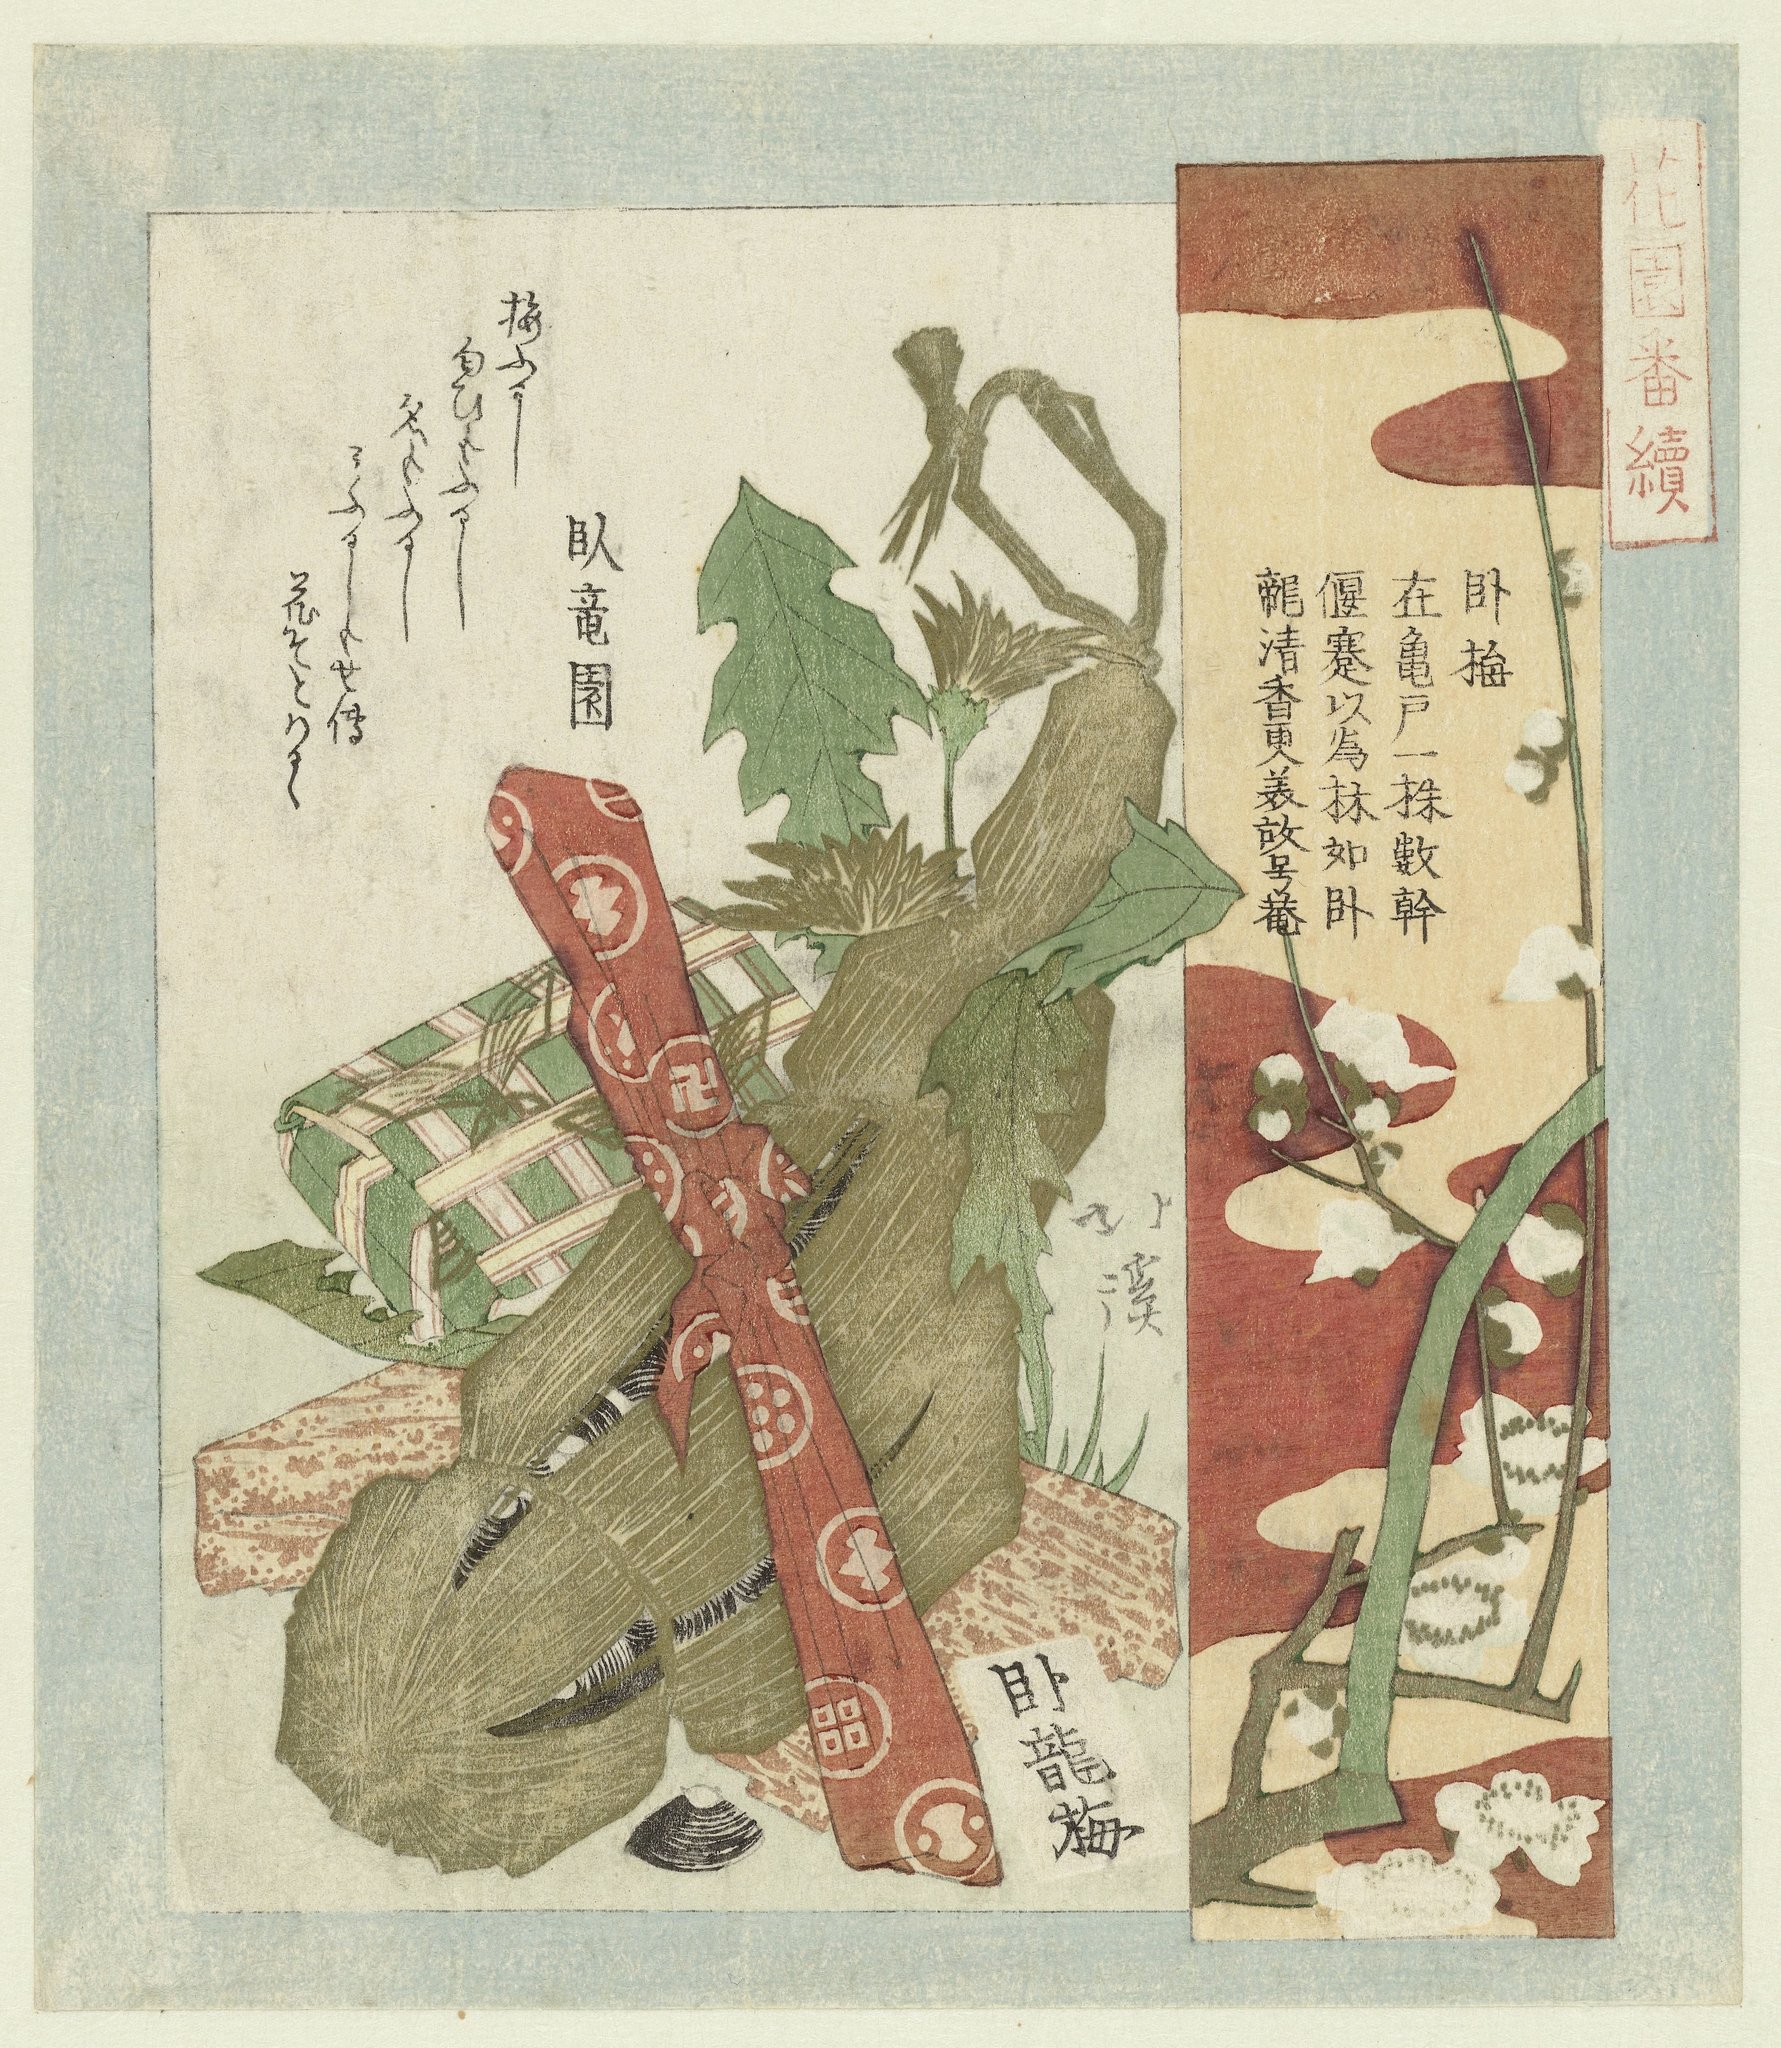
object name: print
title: Gabai pruim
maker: totoya hokkei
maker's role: print maker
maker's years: 1790-1850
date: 1823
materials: paper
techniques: blind stamped, woodcut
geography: japan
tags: plants; vegetation (+ flowers, blossom, blossoming)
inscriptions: collector's mark, verso, stamped: Lugt 2228, collector's mark, passe-partout, bottom left, printed: JABdH with a rooster.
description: Een surimono is een luxe uitgevoerde prent waarop beeld met één of meerdere gedichten gecombineerd is. Bij het drukken van een surimono werd vaak gebruik gemaakt van dikker papier, blinddruk en metaal pigmenten, zoals koper- en zilverpoeder. De prenten werden vaak in opdracht van dichters gemaakt en als exclusief geschenk aan vrienden en relaties gegeven.